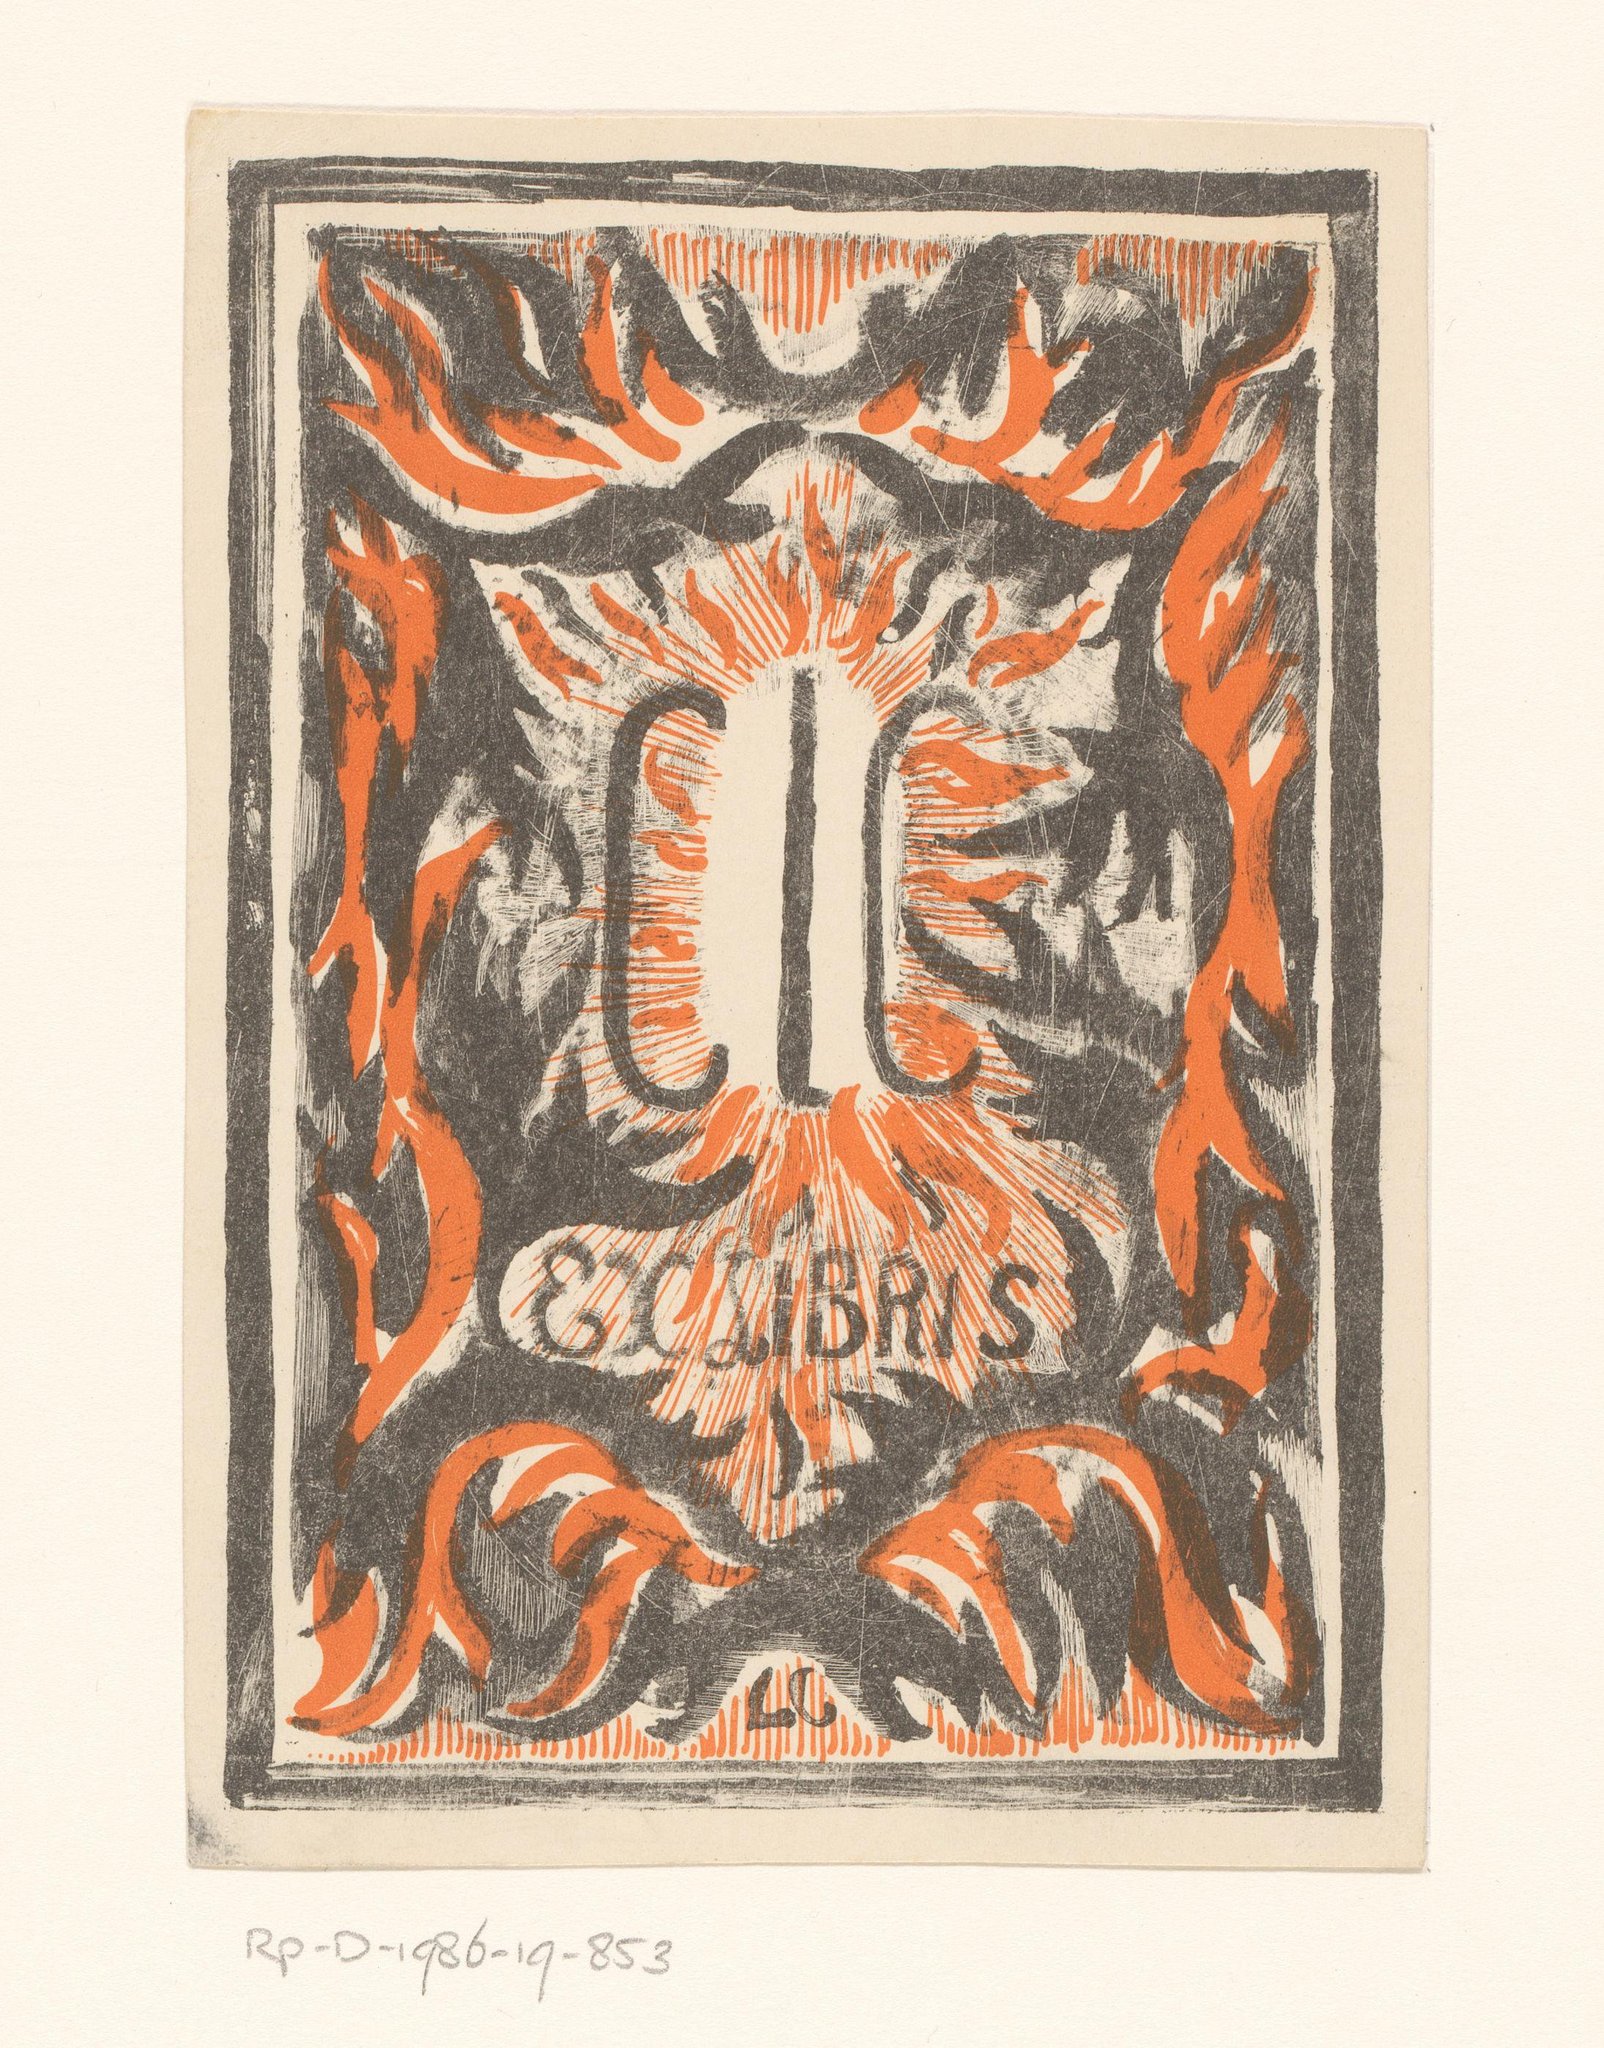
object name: bookplate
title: Ex libris van Carel Lion Cachet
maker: carel adolph lion cachet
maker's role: draughtsman, print maker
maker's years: 1864-1945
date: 1874-1945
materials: paper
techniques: lithograph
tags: draughtsman, carel adolph lion cachet, flame